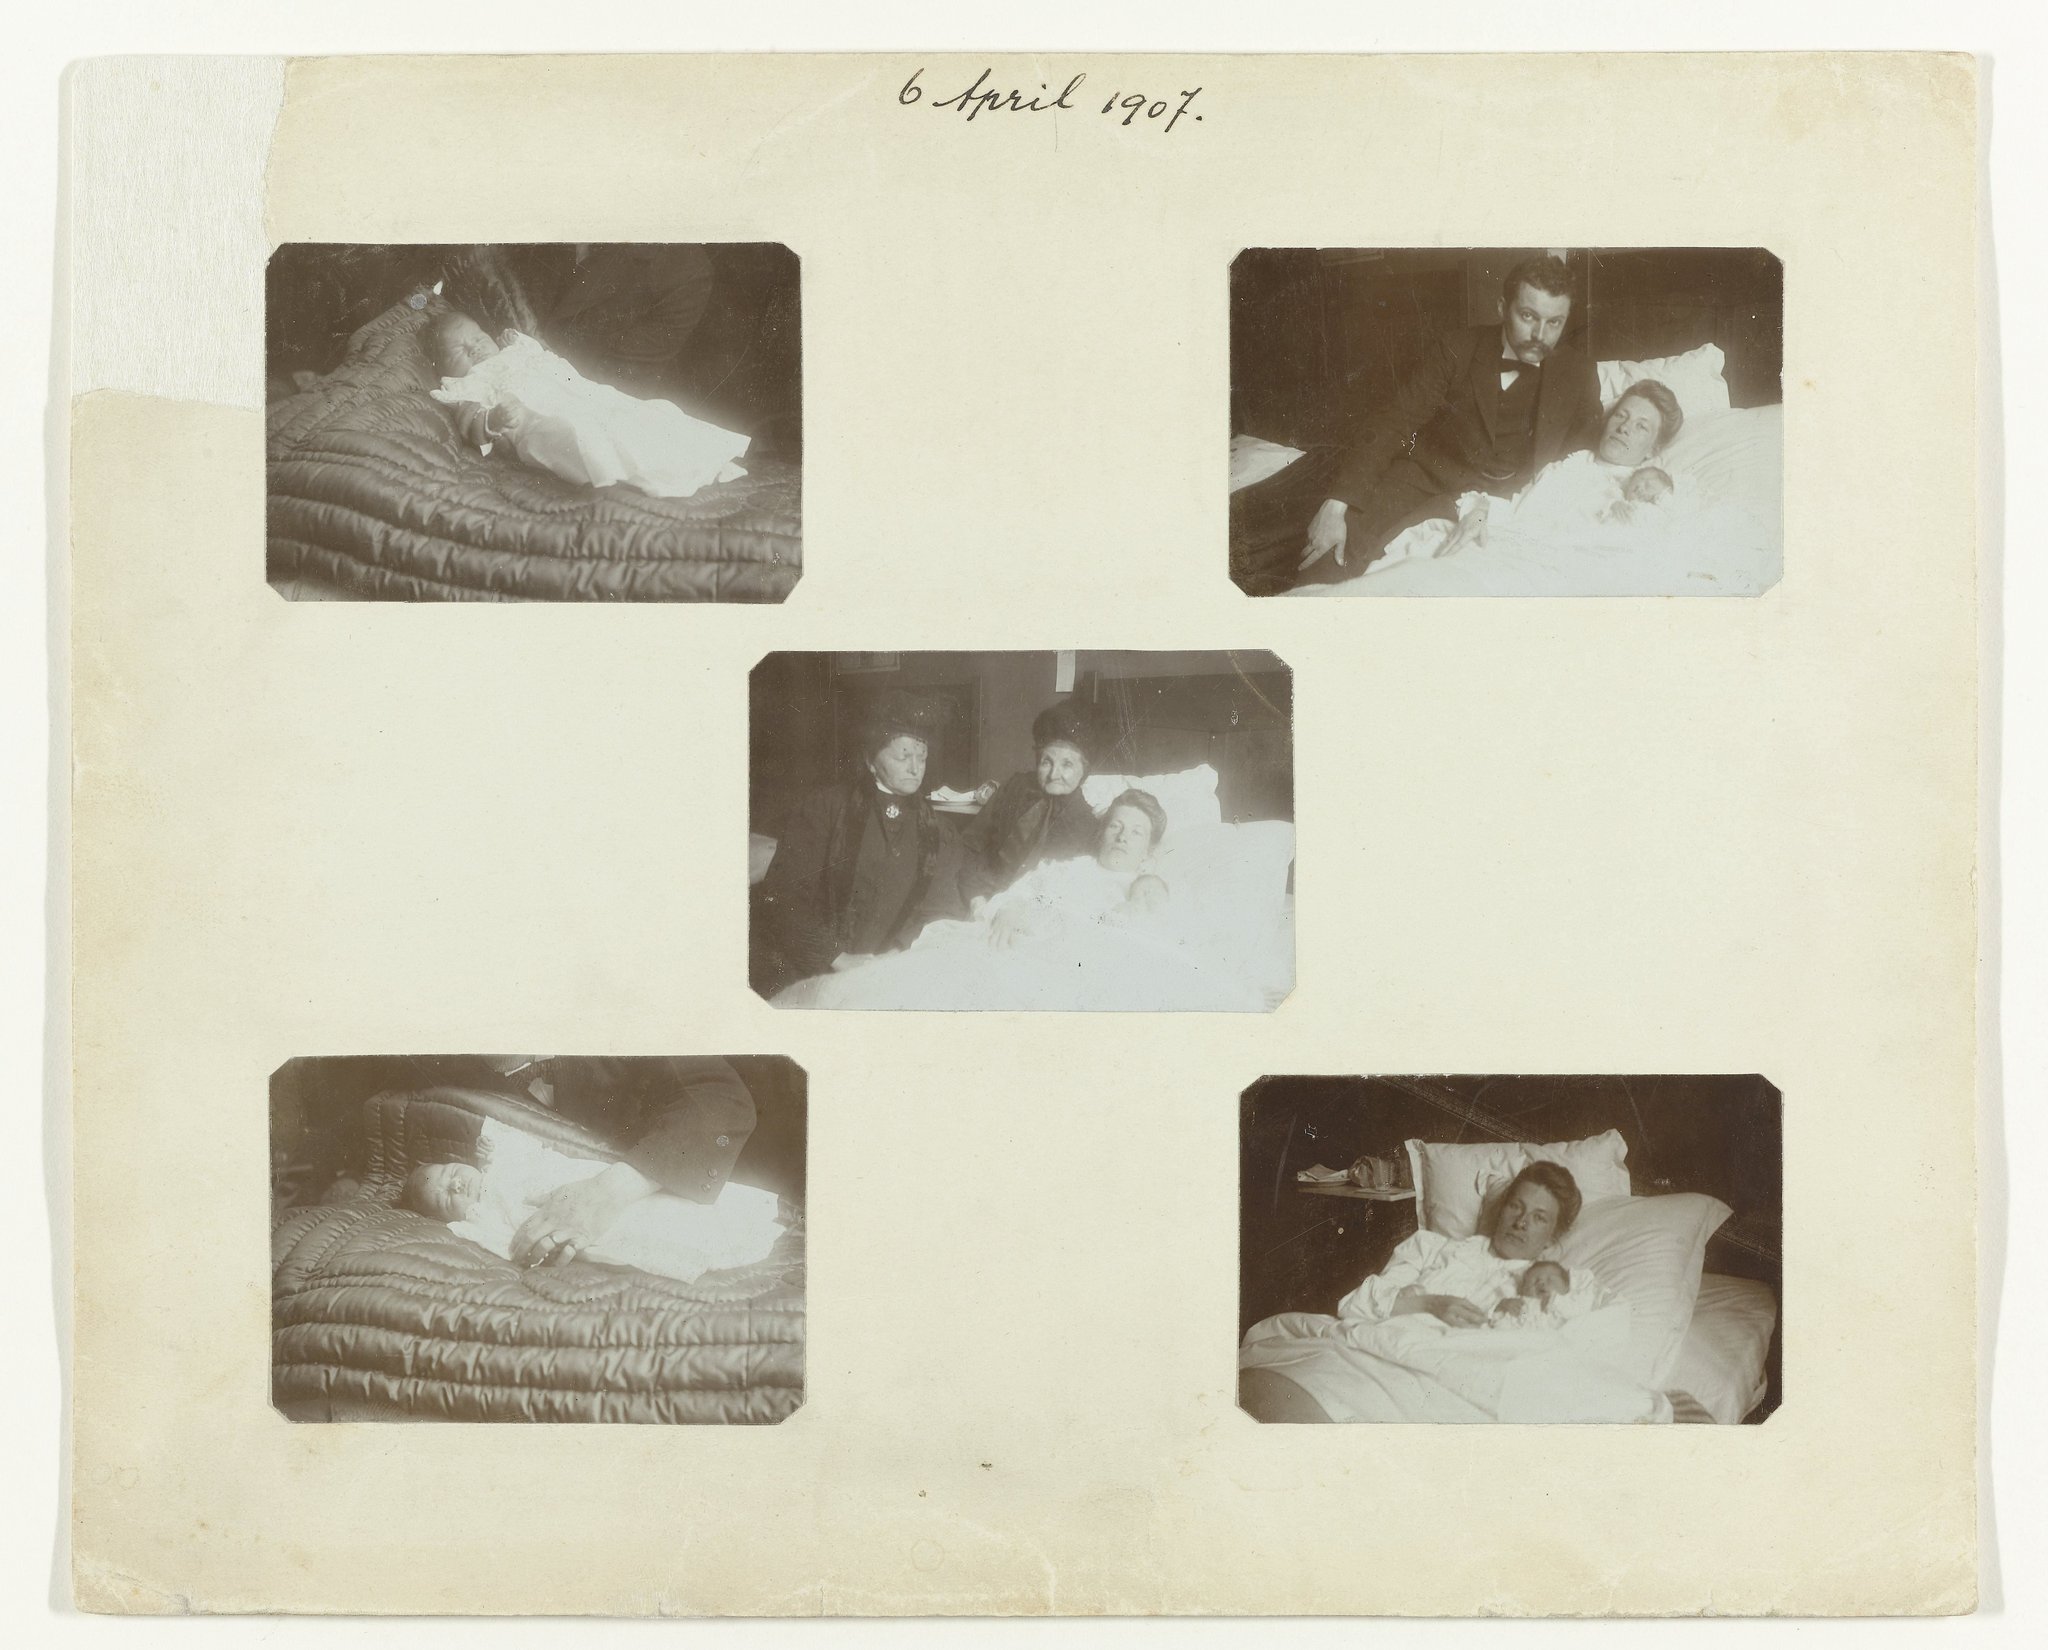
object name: photograph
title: Albumblad met foto's van pasgeboren baby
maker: Anonymous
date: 1907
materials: cardboard, photographic support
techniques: gelatin silver print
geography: netherlands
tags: infant, baby ~ the ages of man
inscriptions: date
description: Vijf foto's op een albumblad geplakt, Twee van een pasgeboren baby op een sprei vastgehouden door de vader, één bij de moeder in bed, één met beide ouders en één met de moeder en twee oudere vrouwen.